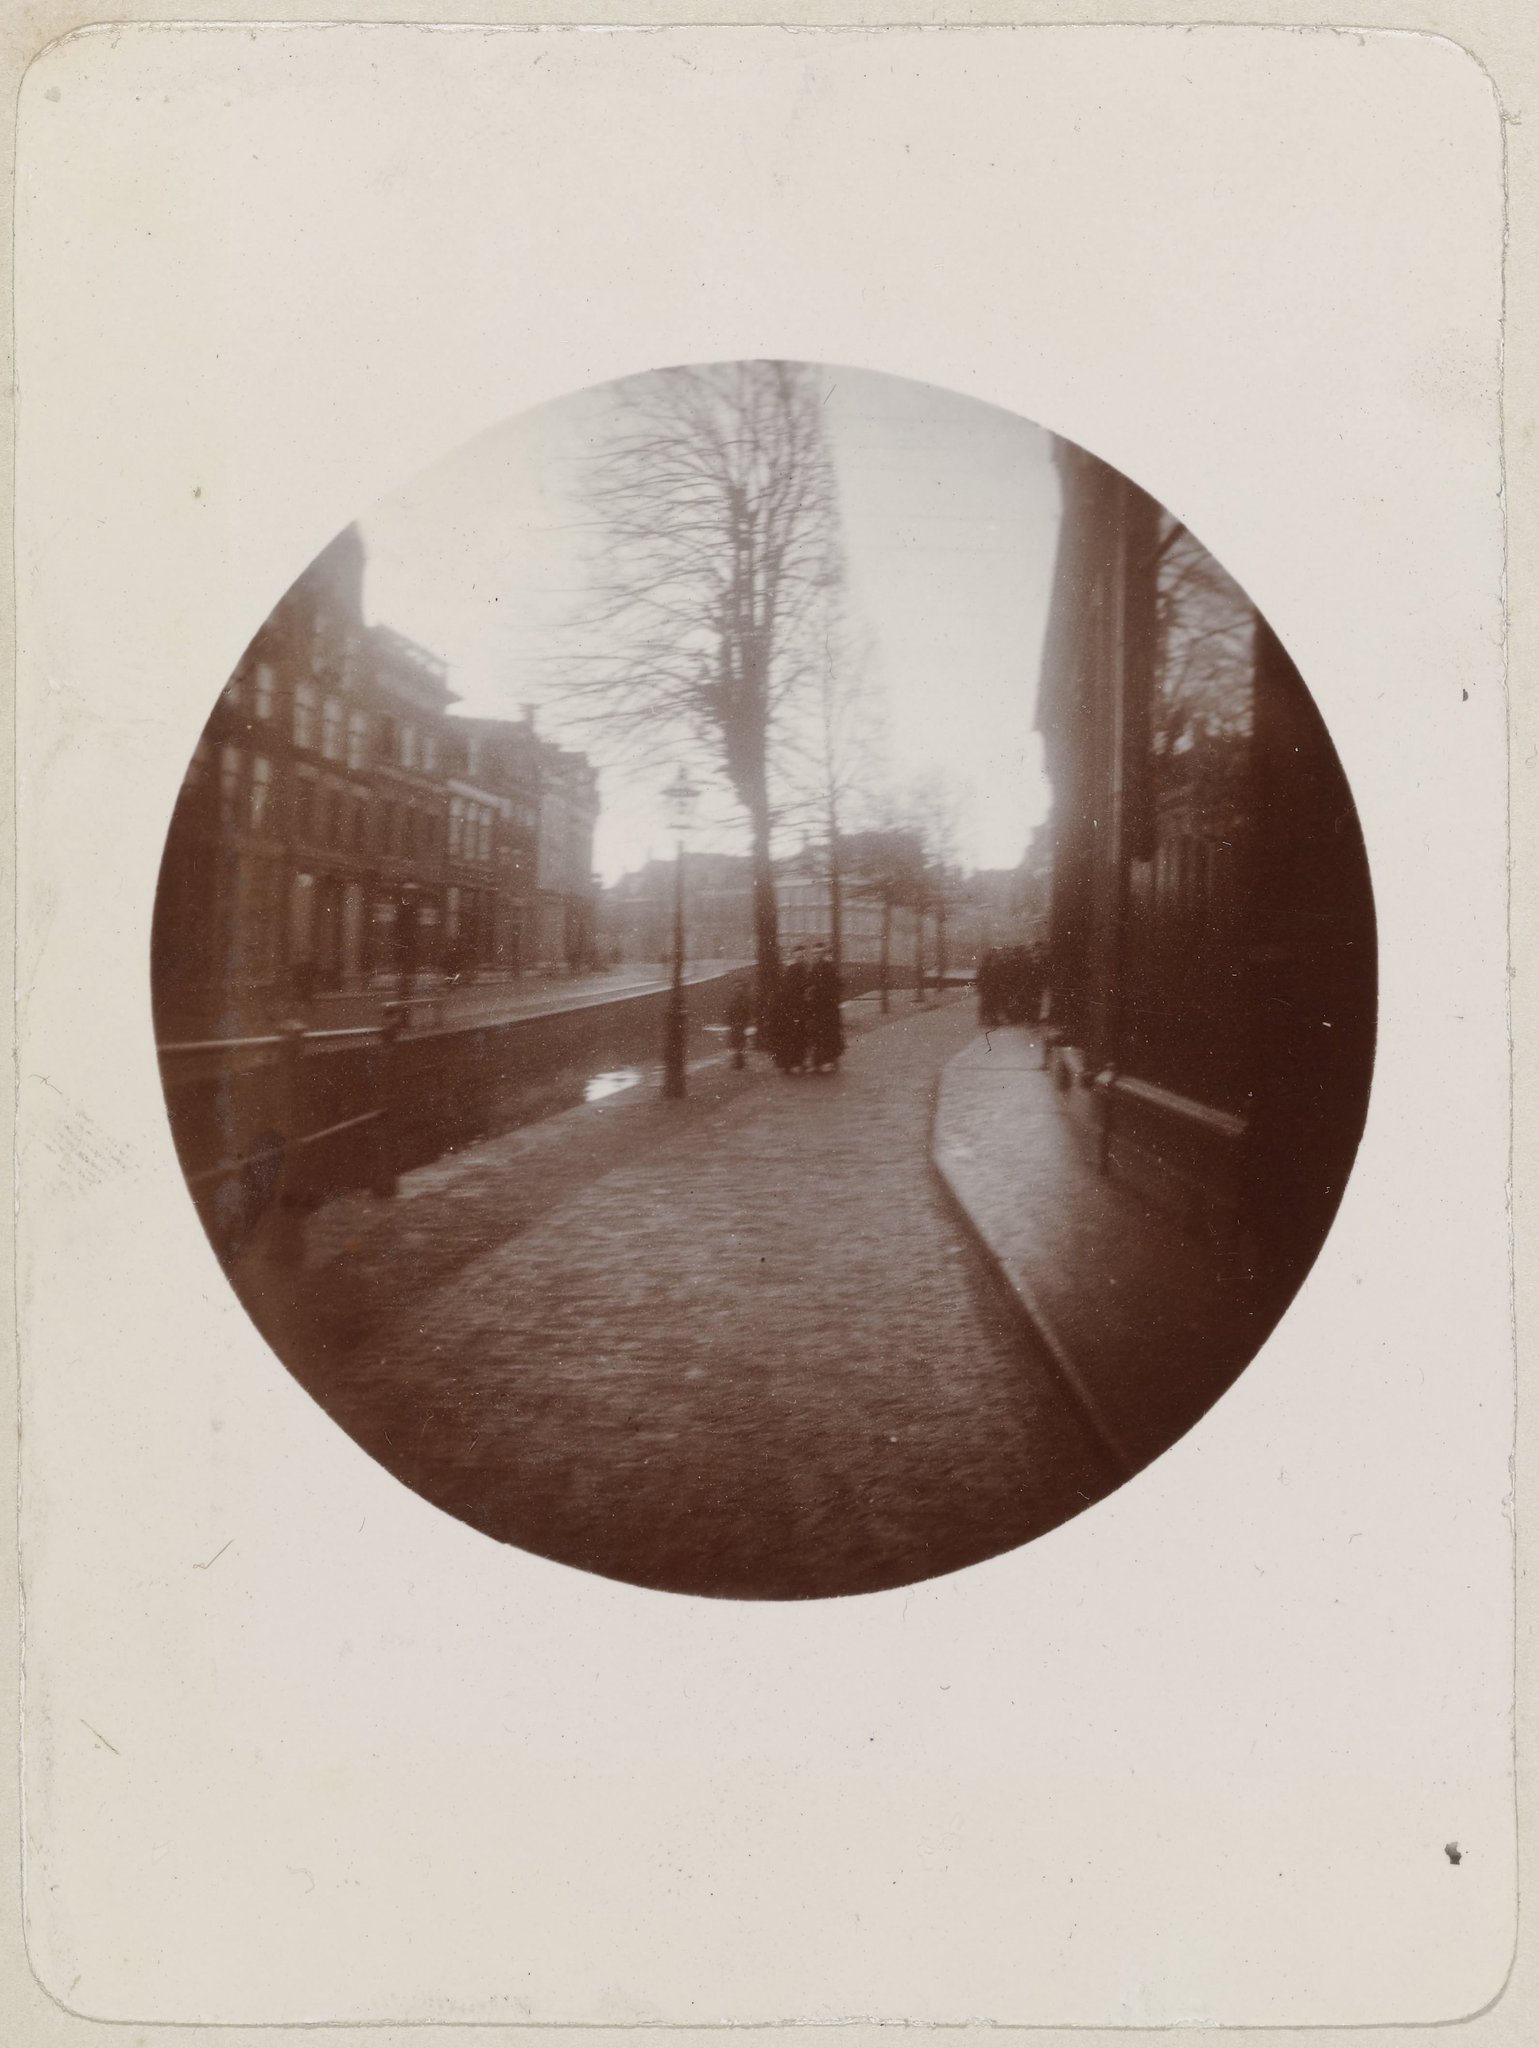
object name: photograph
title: Page from an Album with Circular Kodak Snapshots of Leeuwarden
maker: Anonymous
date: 1897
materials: paper, cardboard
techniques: gelatin silver print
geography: leeuwarden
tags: street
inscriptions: annotation: ‘Photographs taken with the first Kodak Camera’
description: De Kelders te Leeuwarden gezien vanaf de hoek Minnemastraat, met mensen lopend op de kade. De foto is onderdeel van een albumblad met daarop foto's van Leeuwarden.